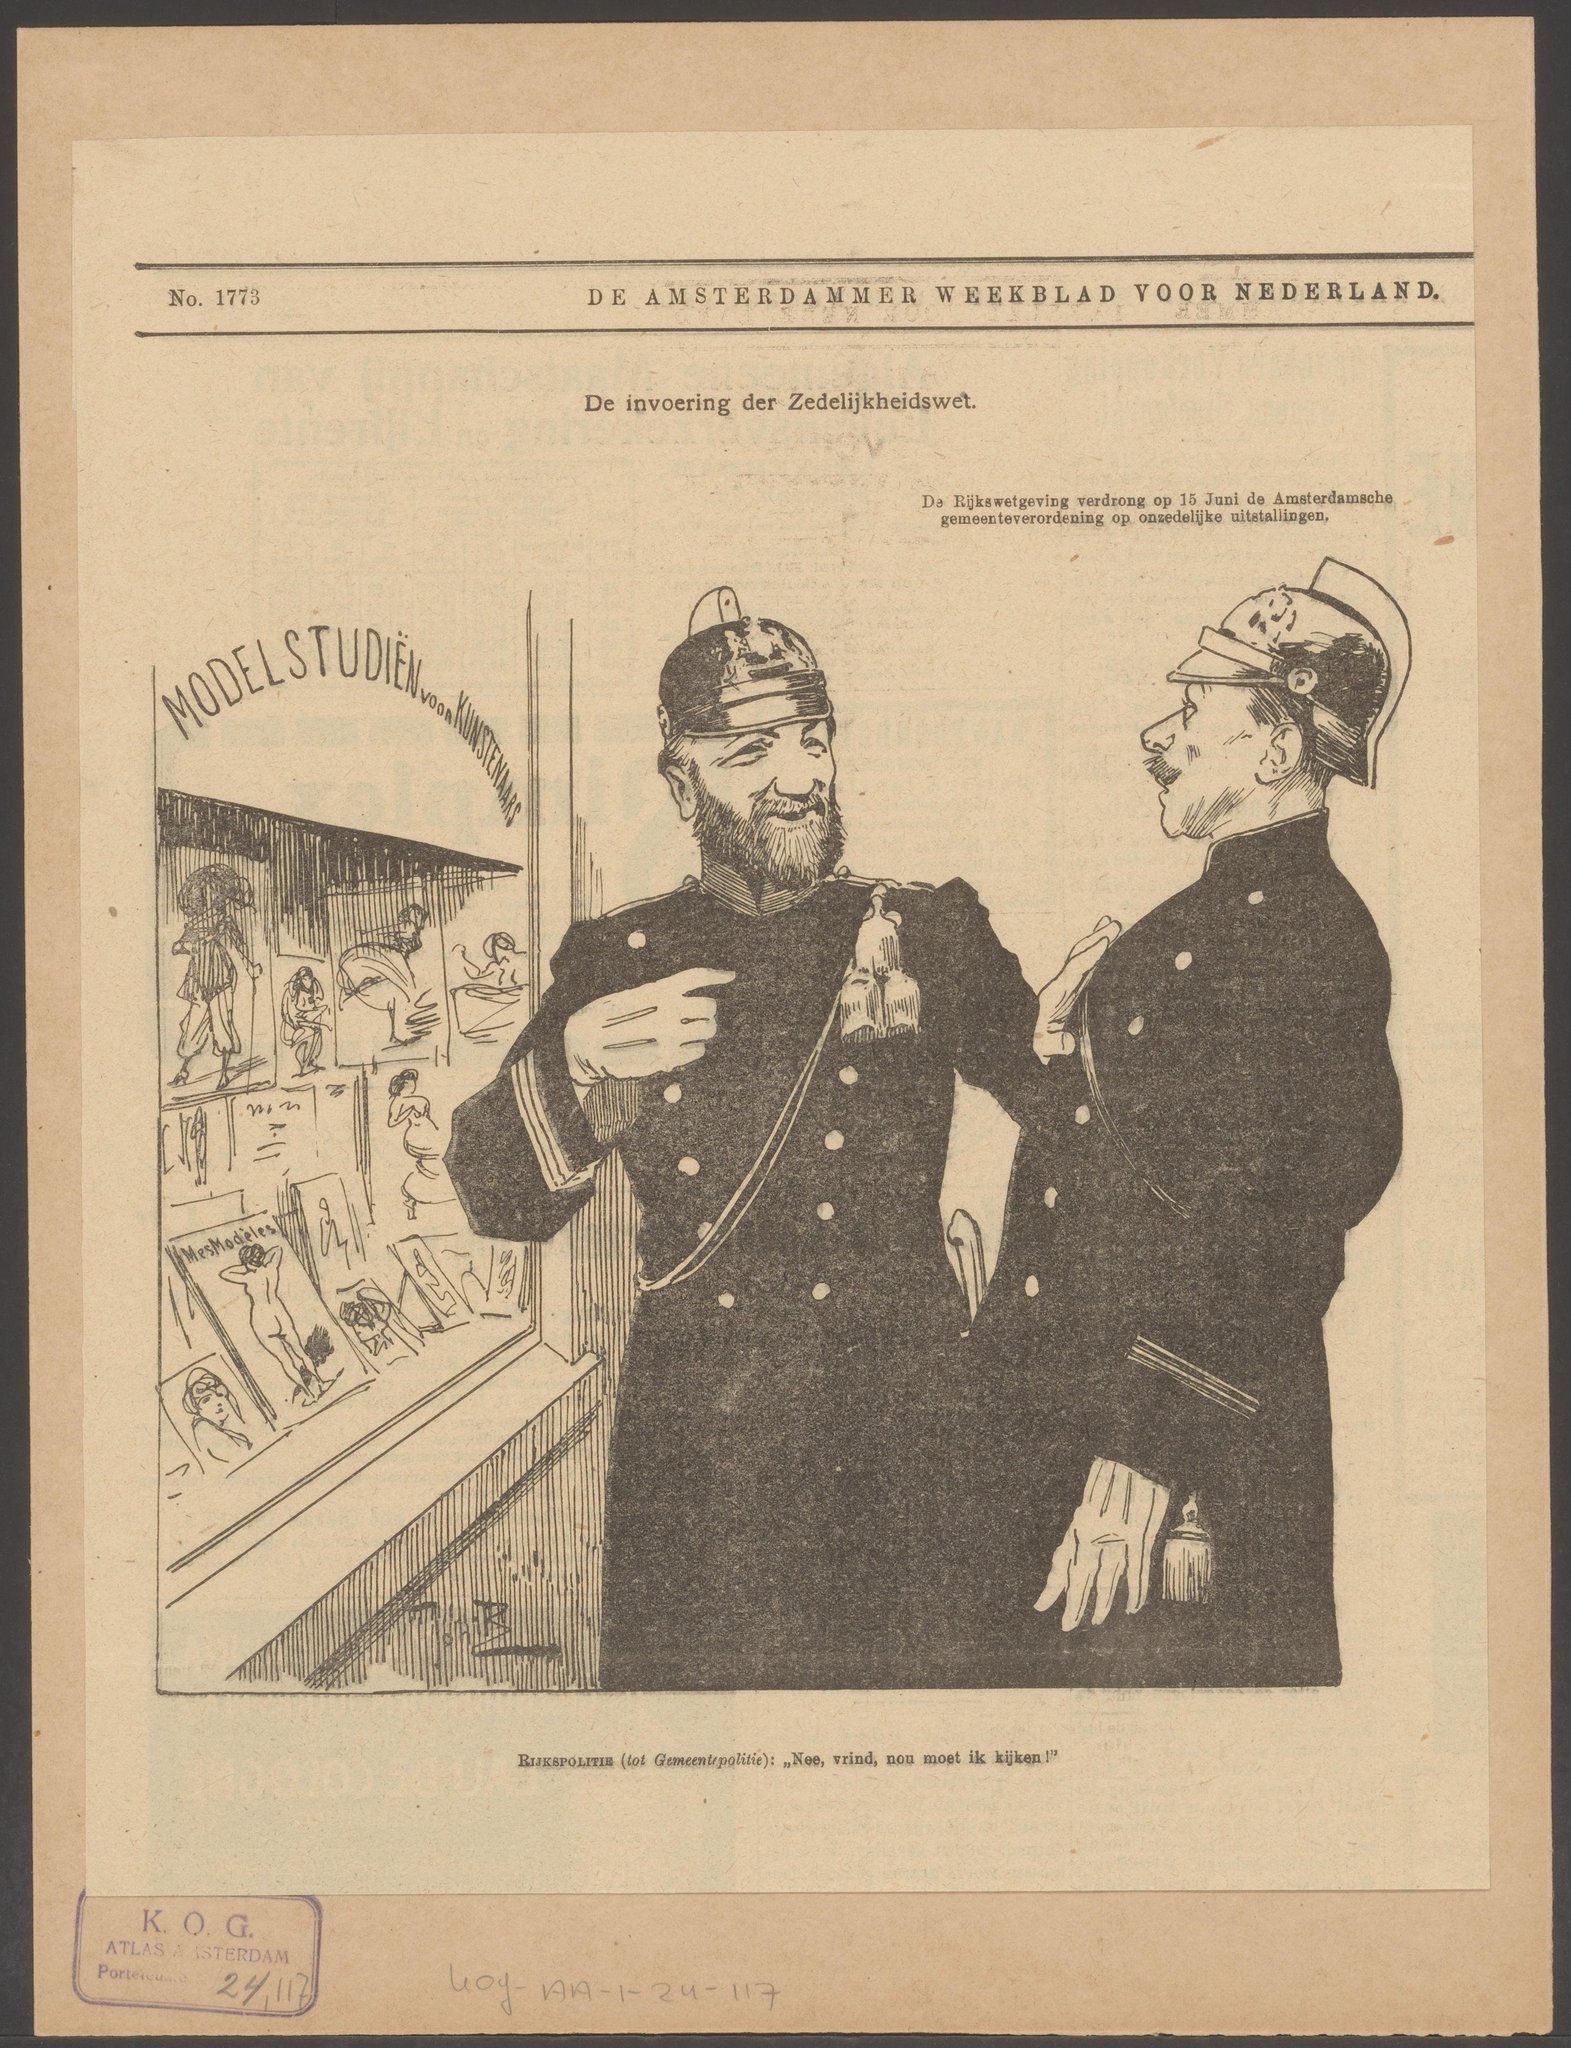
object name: photomechanical print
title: De invoering der Zedelijkheidswet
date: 1911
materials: paper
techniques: letterpress printing, line block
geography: netherlands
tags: morality, policeman, constable, amsterdam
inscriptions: collector's mark: Lugt 1641b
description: Prent uit: De Amsterdammer 35 (1911), nr. 1773, 18 juni 1911, p. 13.